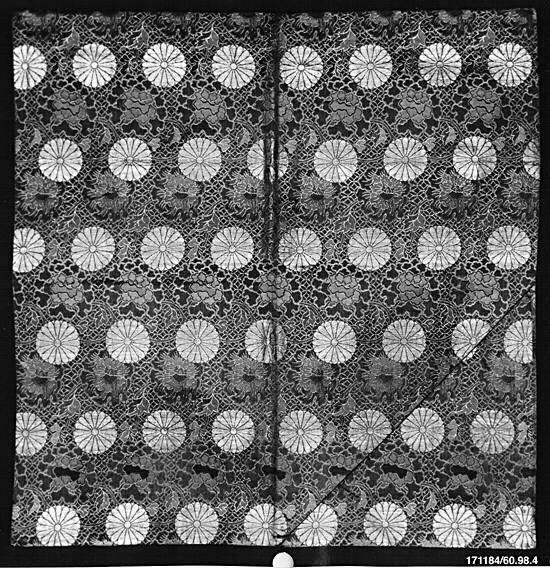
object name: altar cloth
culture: japanese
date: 1701-1800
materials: metal thread, silk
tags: flowers